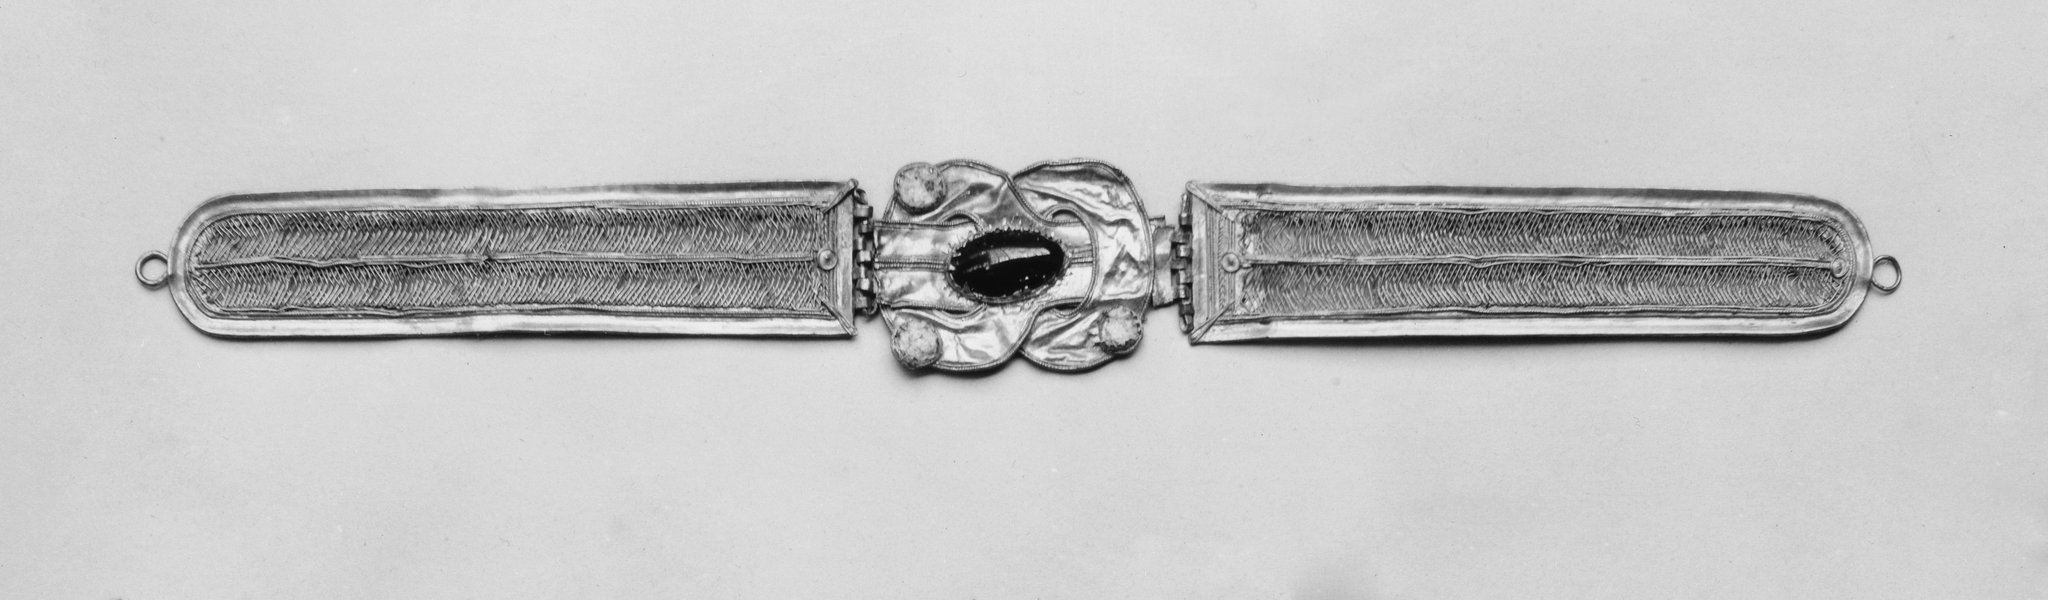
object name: diadem with garnet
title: Gold and garnet strap diadem with Herakles knot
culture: greek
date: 300-101 BCE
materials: gemstone, gold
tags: diadems